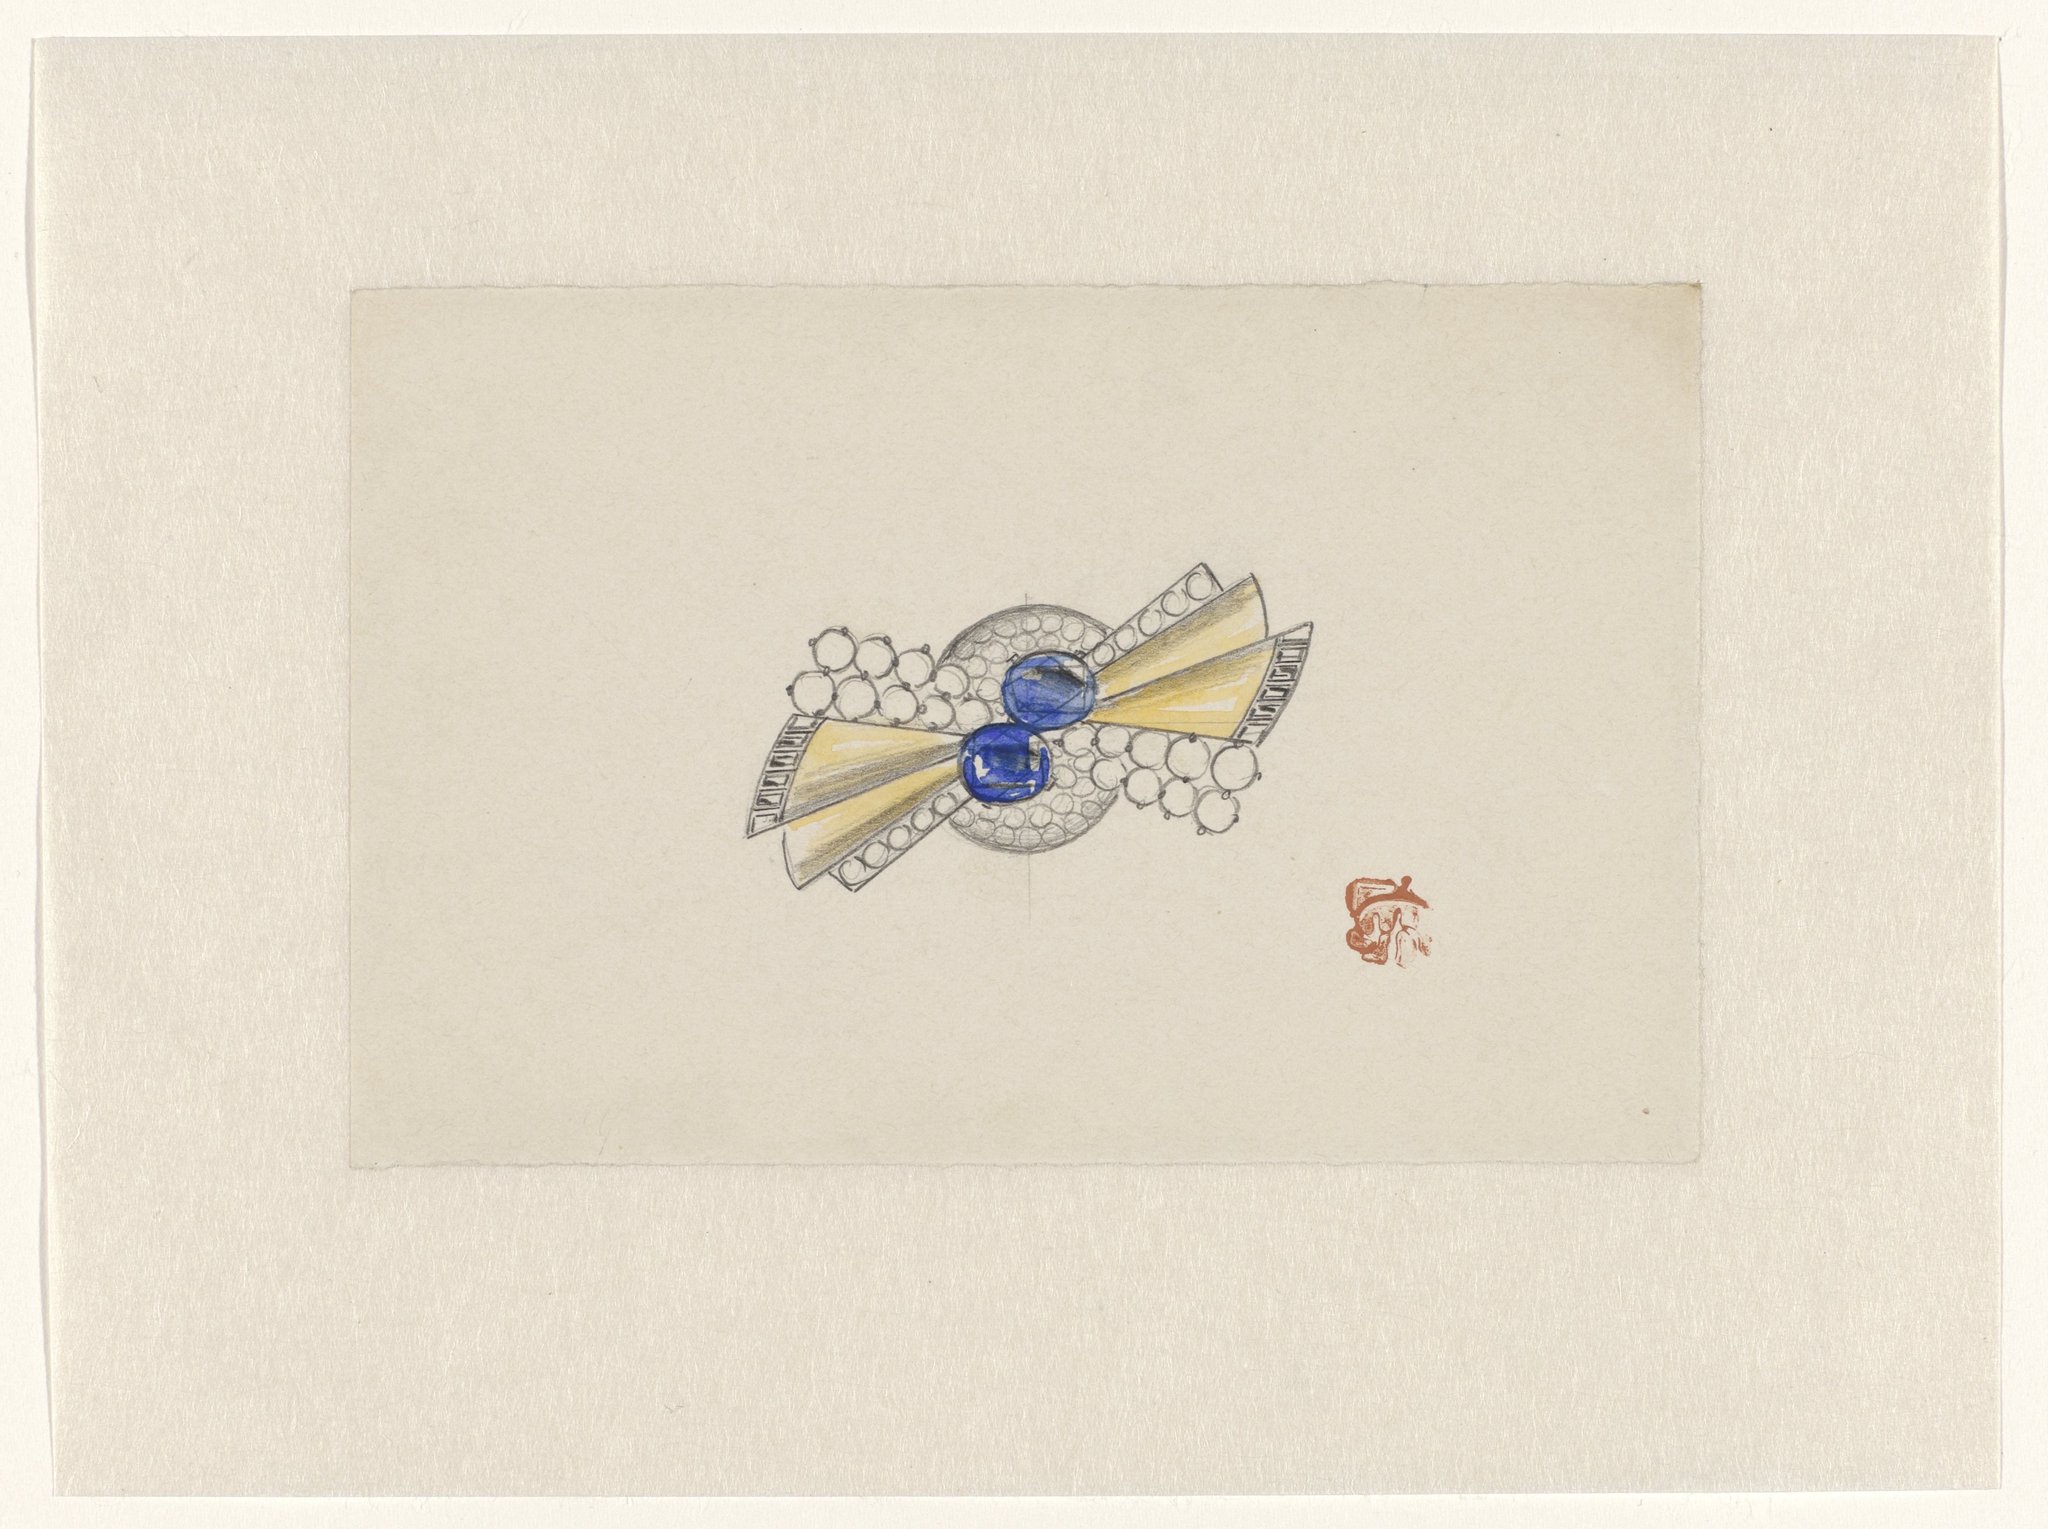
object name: drawing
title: Ontwerp voor een rond juweel met stralen, met goud, saffieren en briljanten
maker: jules chadel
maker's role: draughtsman, print maker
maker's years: 1870-1941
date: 1920-1930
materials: paper, pencil, watercolor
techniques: brush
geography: paris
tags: ornaments, jewels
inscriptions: stamp: Lugt 562 b